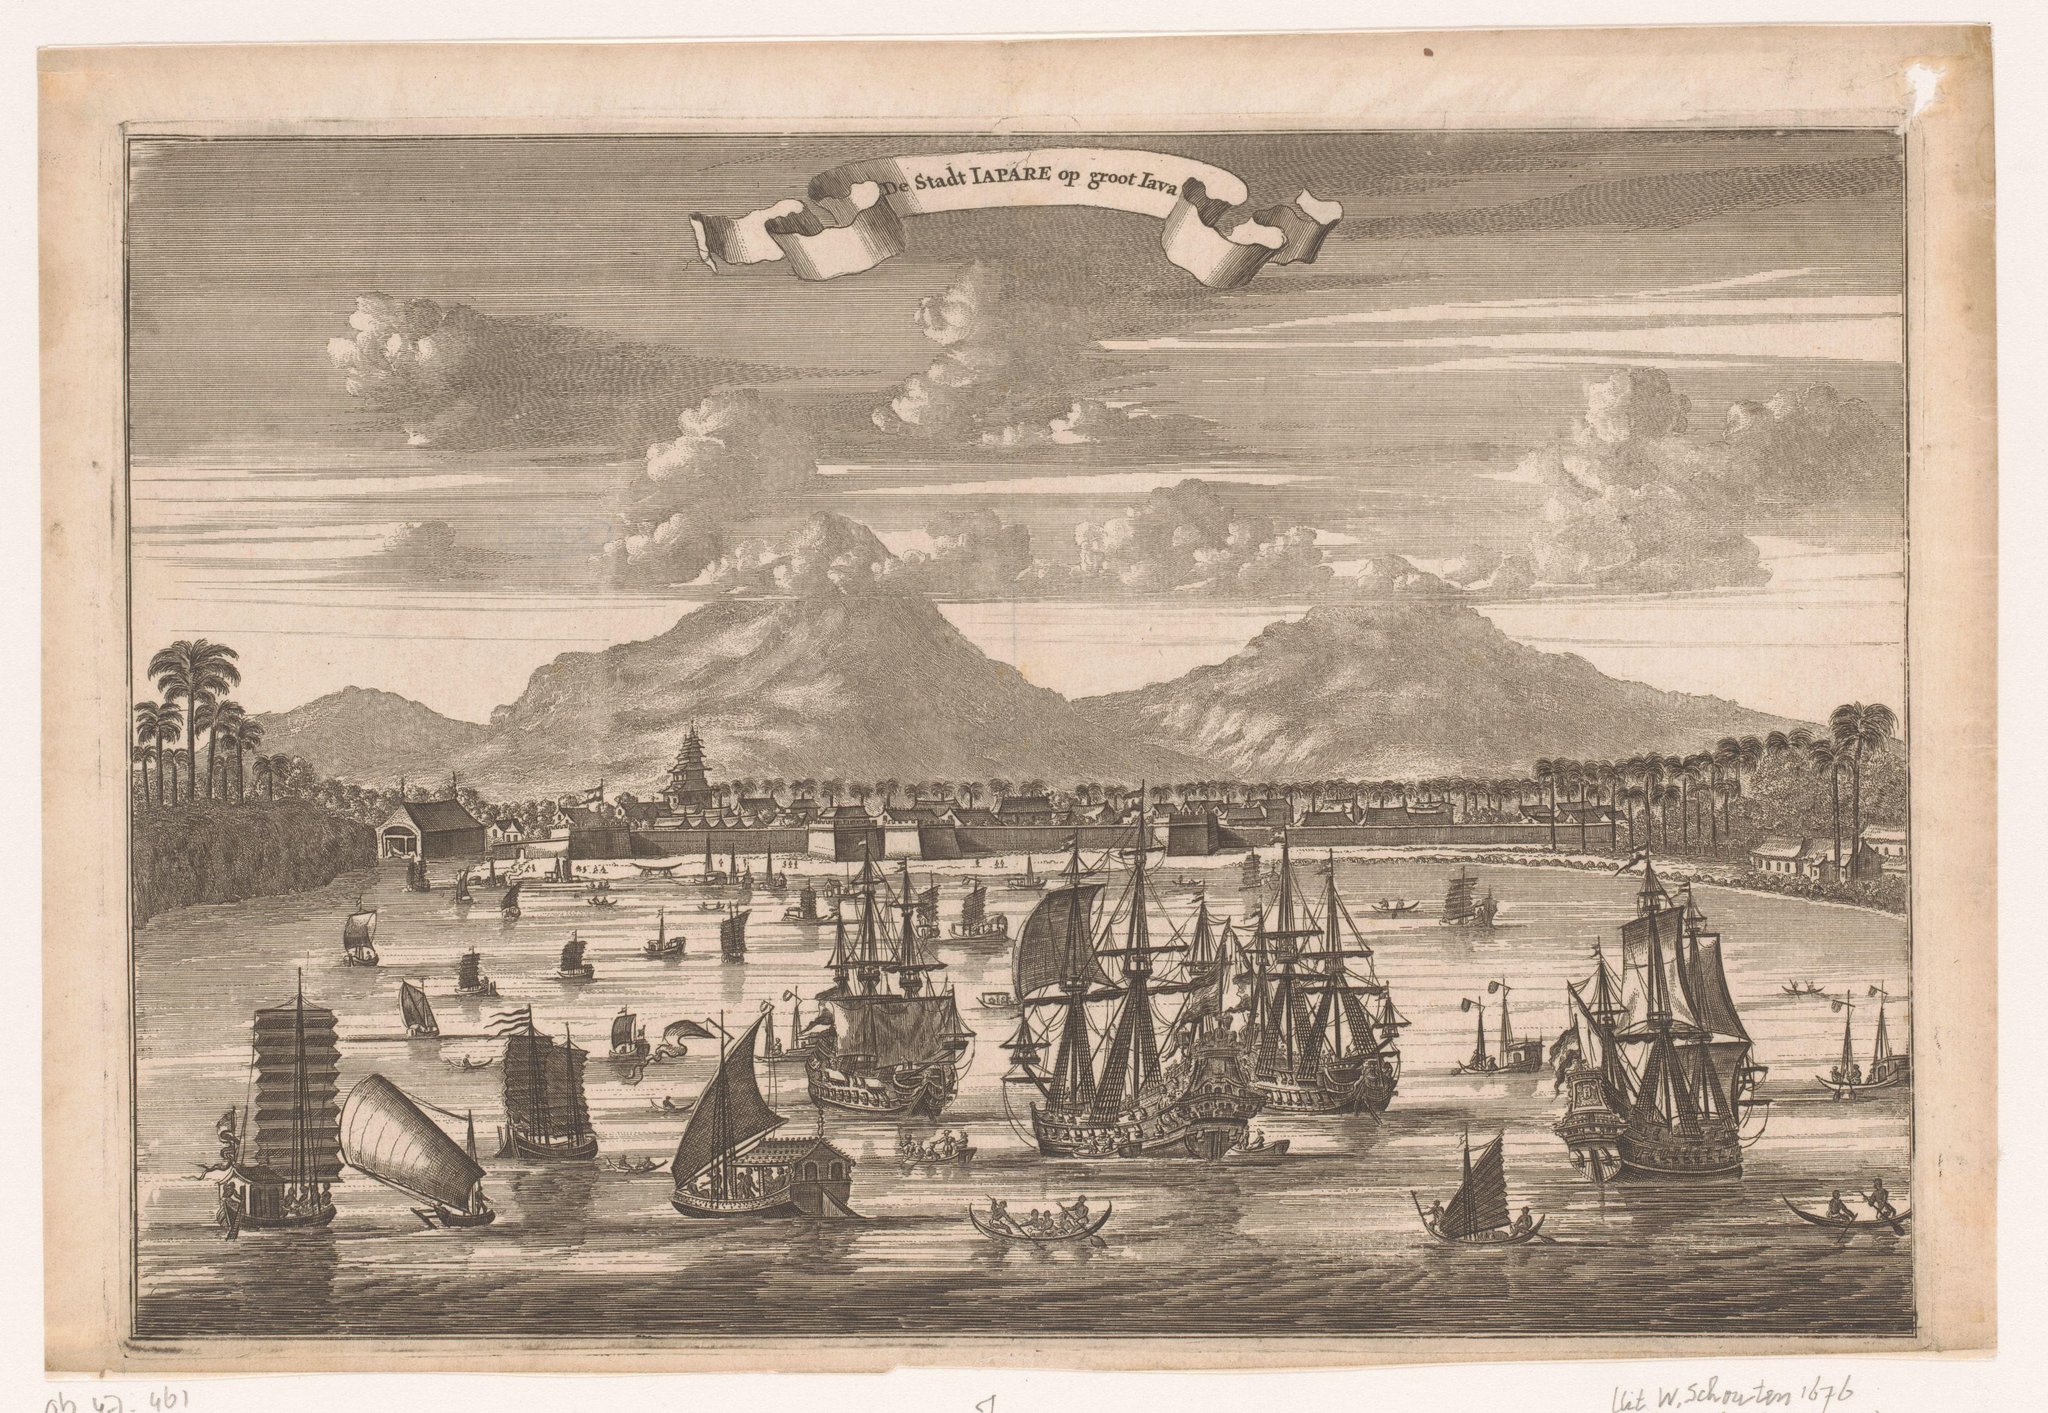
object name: print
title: De Stadt Japare op groot Java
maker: coenraet decker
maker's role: print maker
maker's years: 1650-1685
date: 1775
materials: paper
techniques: engraving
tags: repairing, caulking, careening (~ ship), permanent fortifications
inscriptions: collector's mark: Lugt 2228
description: Prent uit: Schouten, Wouter. Reistogt naar en door Oostindiën. 2 dln. Utrecht: Wed. J.J. van Poolsum, G.T. van Paddenburg, A. van Paddenburg, J. van Schoonhoven en Comp., en Amsterdam: M. de Bruyn, 1775, dl. 1, p. 40.